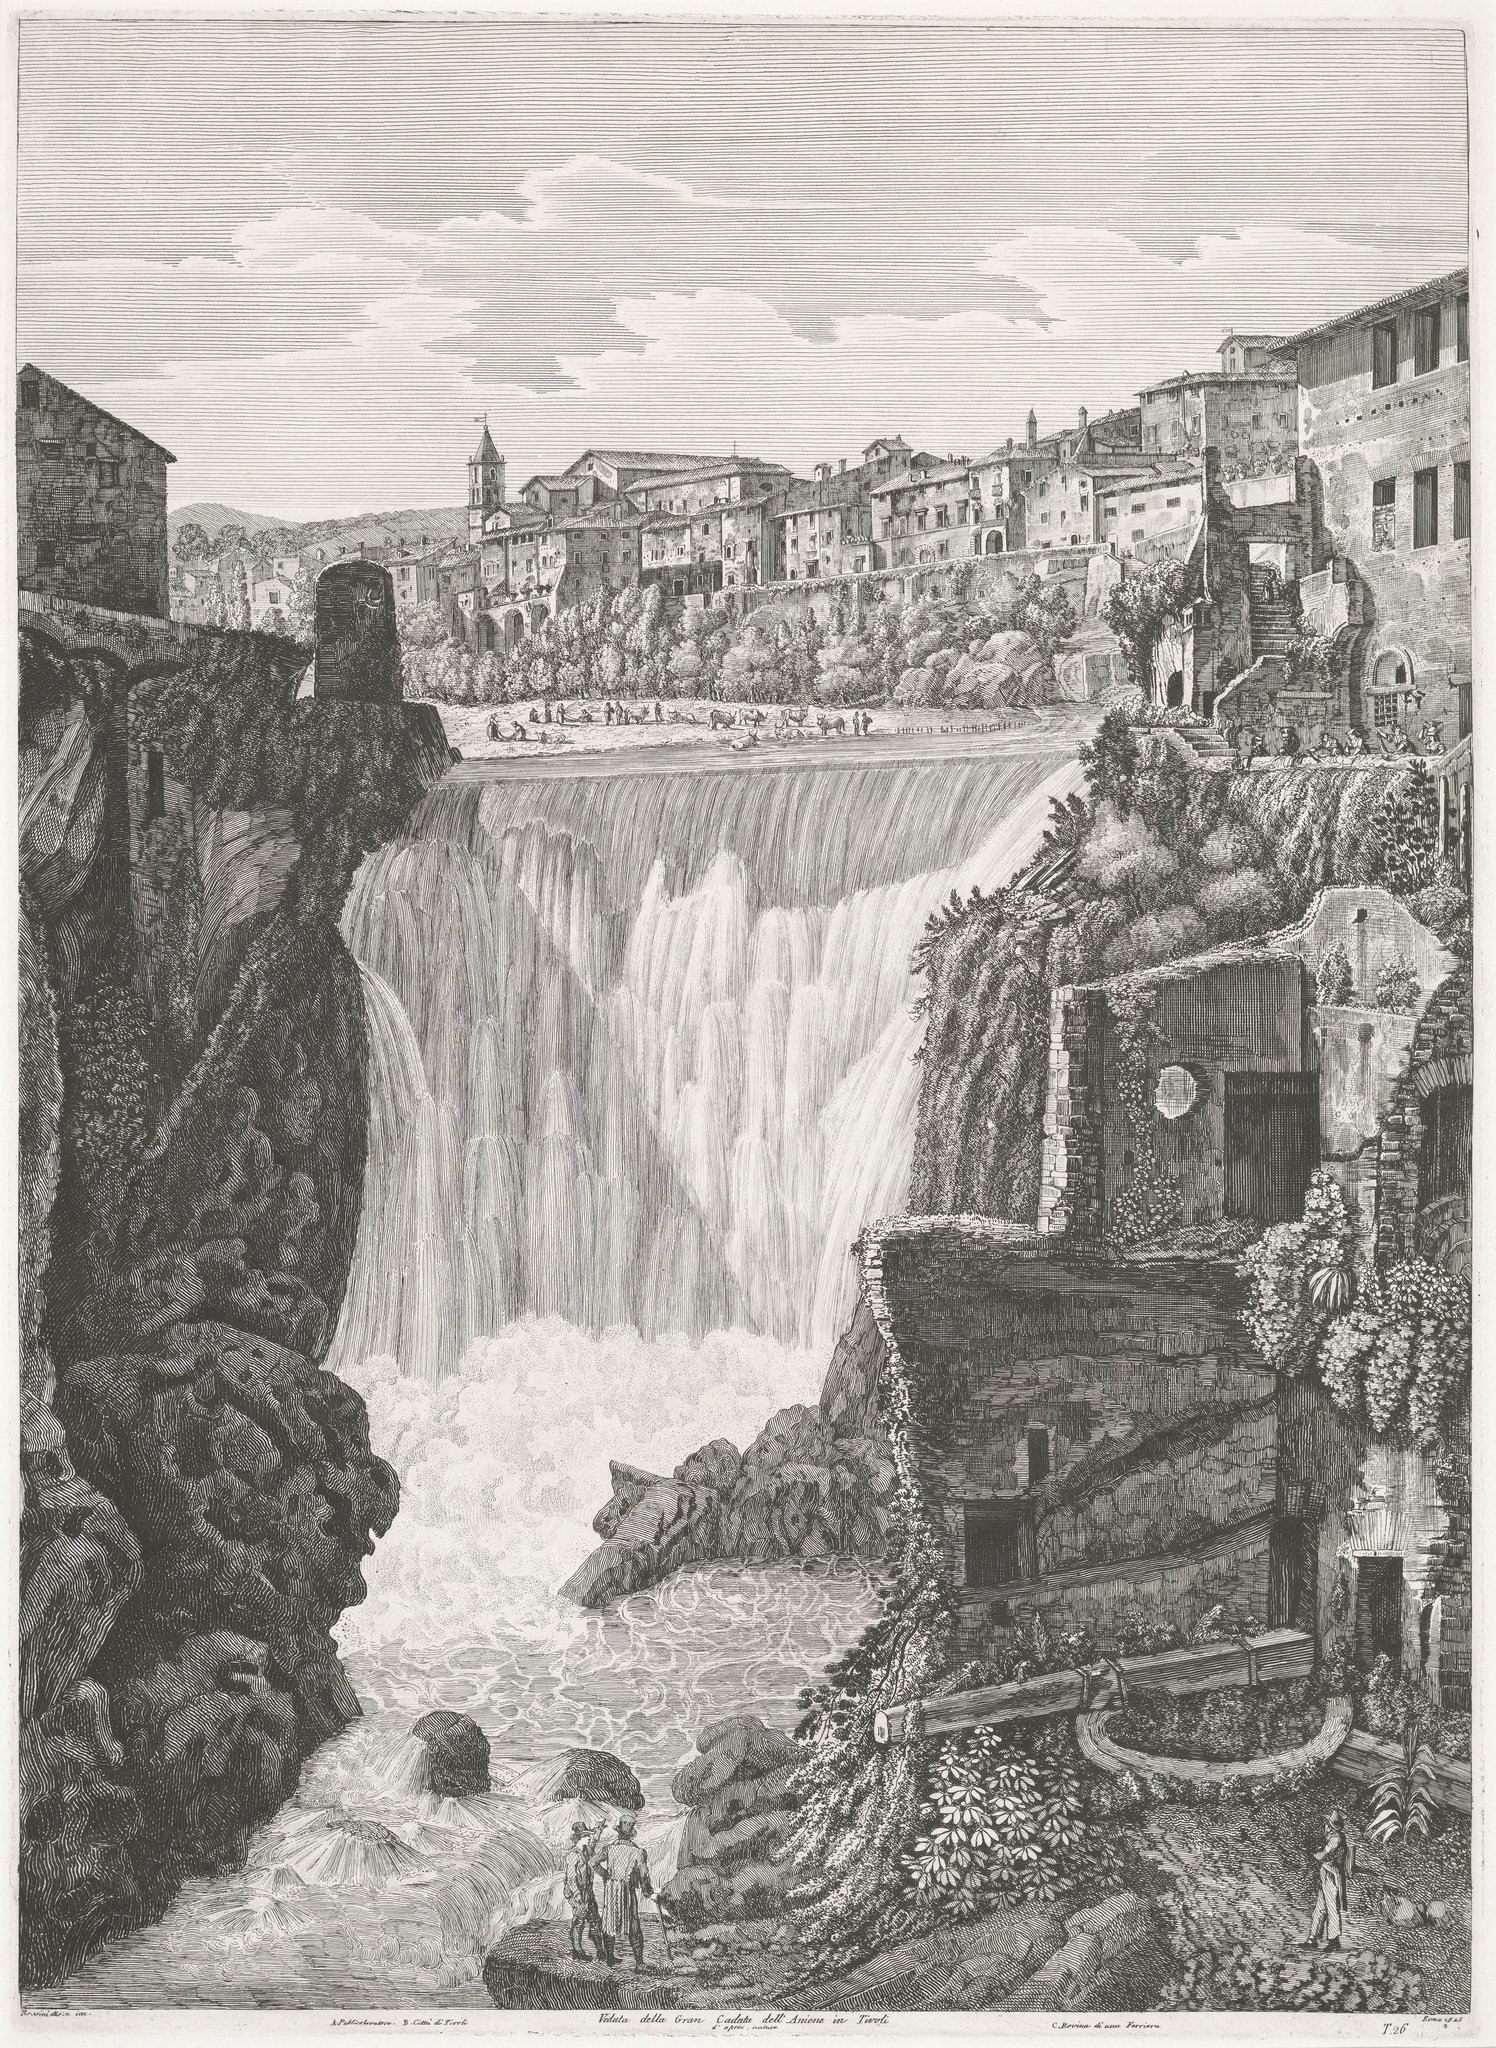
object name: print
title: Veduta della Gran Caduta dell' Aniene in Tivoli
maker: luigi rossini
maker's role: print maker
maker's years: 1790-1857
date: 1825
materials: paper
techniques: etching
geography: rome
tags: landscapes, waterfall, tivoli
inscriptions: collector's mark: Lugt 2760, collector's mark: Lugt 2228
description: Gezicht op de grote watervallen bij Tivoli, van laag standpunt gezien. Op de voorgrond, op de rechteroever, twee mannen van wie er een naar de watervallen wijst. Rechts een man met tekenmap onder de arm. Genummerd rechtsonder: T. 26.